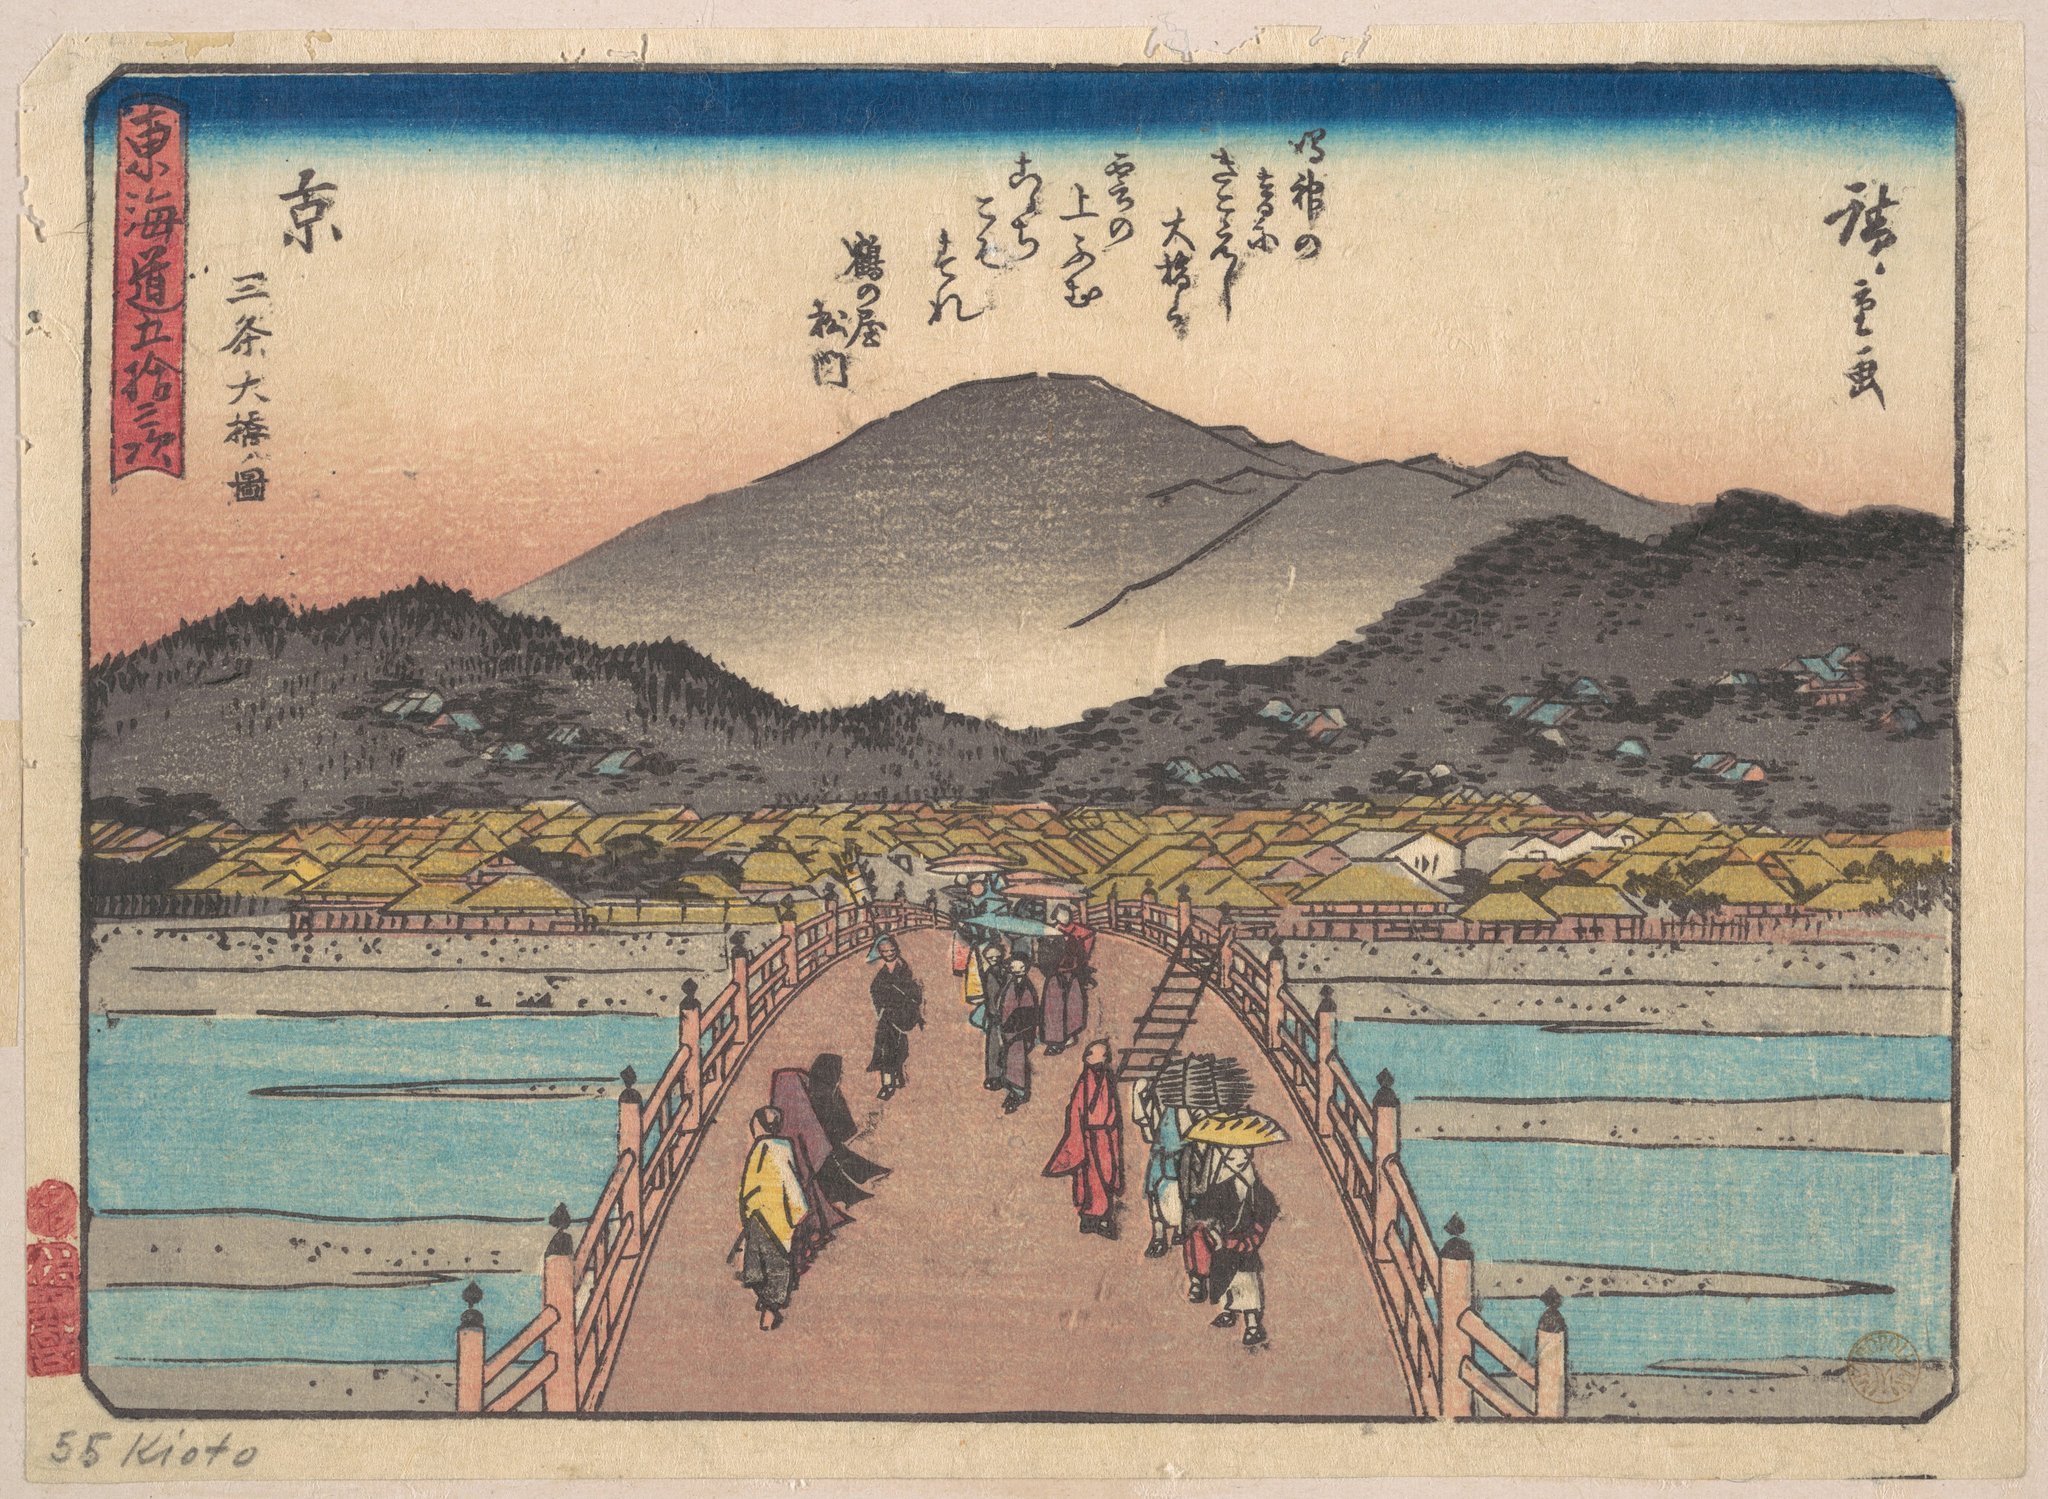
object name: print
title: Kyoto: Sanju Ohashi no zu.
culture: japanese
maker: utagawa hiroshige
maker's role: artist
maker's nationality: japanese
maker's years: 1797-1858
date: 1838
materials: ink, paper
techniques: woodblock print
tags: human figures,bridges,mountains